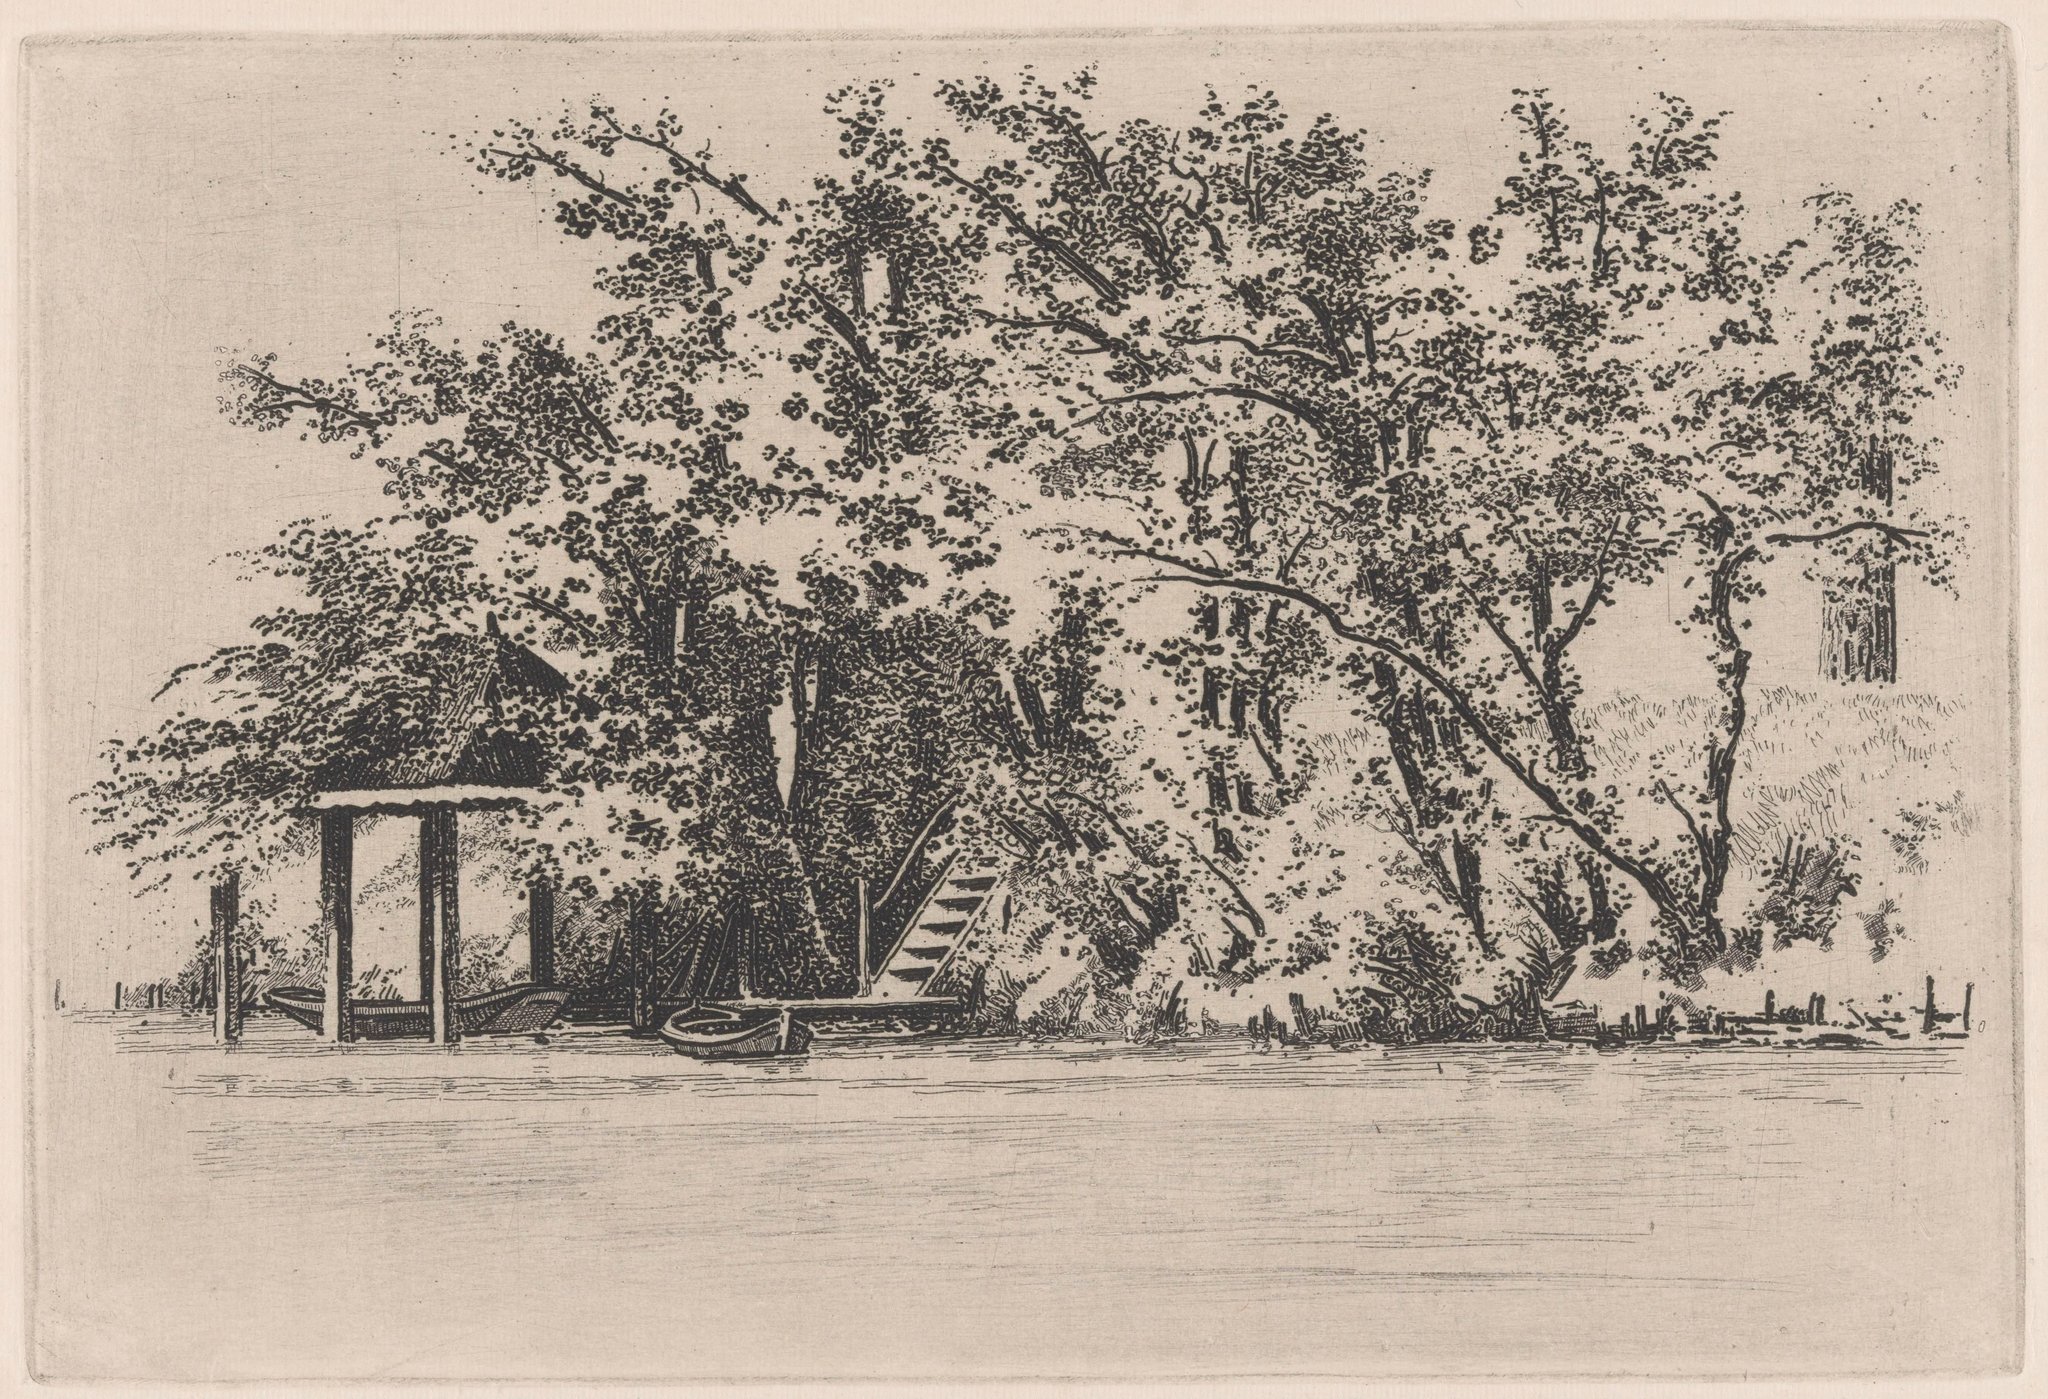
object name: print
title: Siermotief met acht bloemen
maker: carel adolph lion cachet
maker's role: draughtsman, print maker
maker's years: 1864-1945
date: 1874-1945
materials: paper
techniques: printing block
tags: flowers ~ ornament - aa - stylized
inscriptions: collector's mark: Lugt 2228